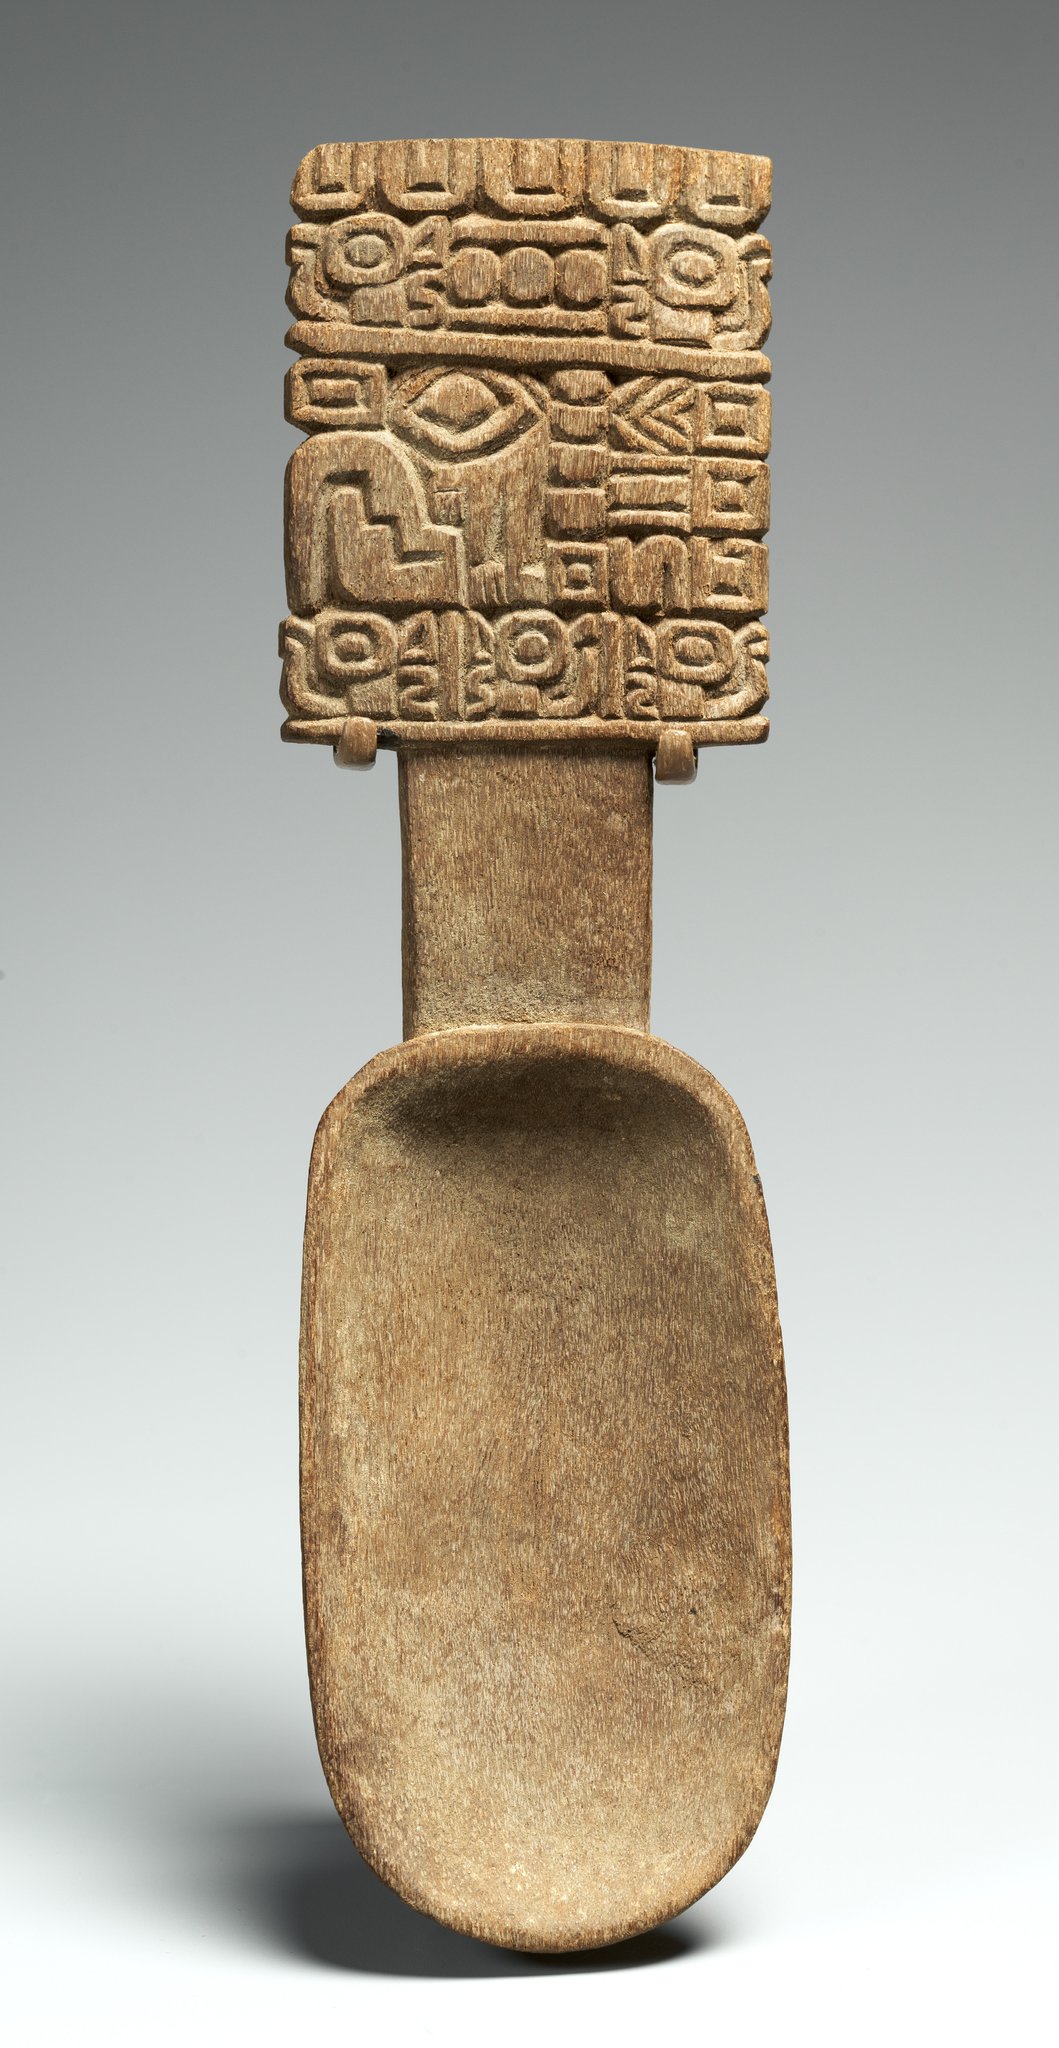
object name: spoon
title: Ceremonial spoon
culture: wari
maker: wari artist(s)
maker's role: artist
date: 650-1000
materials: wood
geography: peru